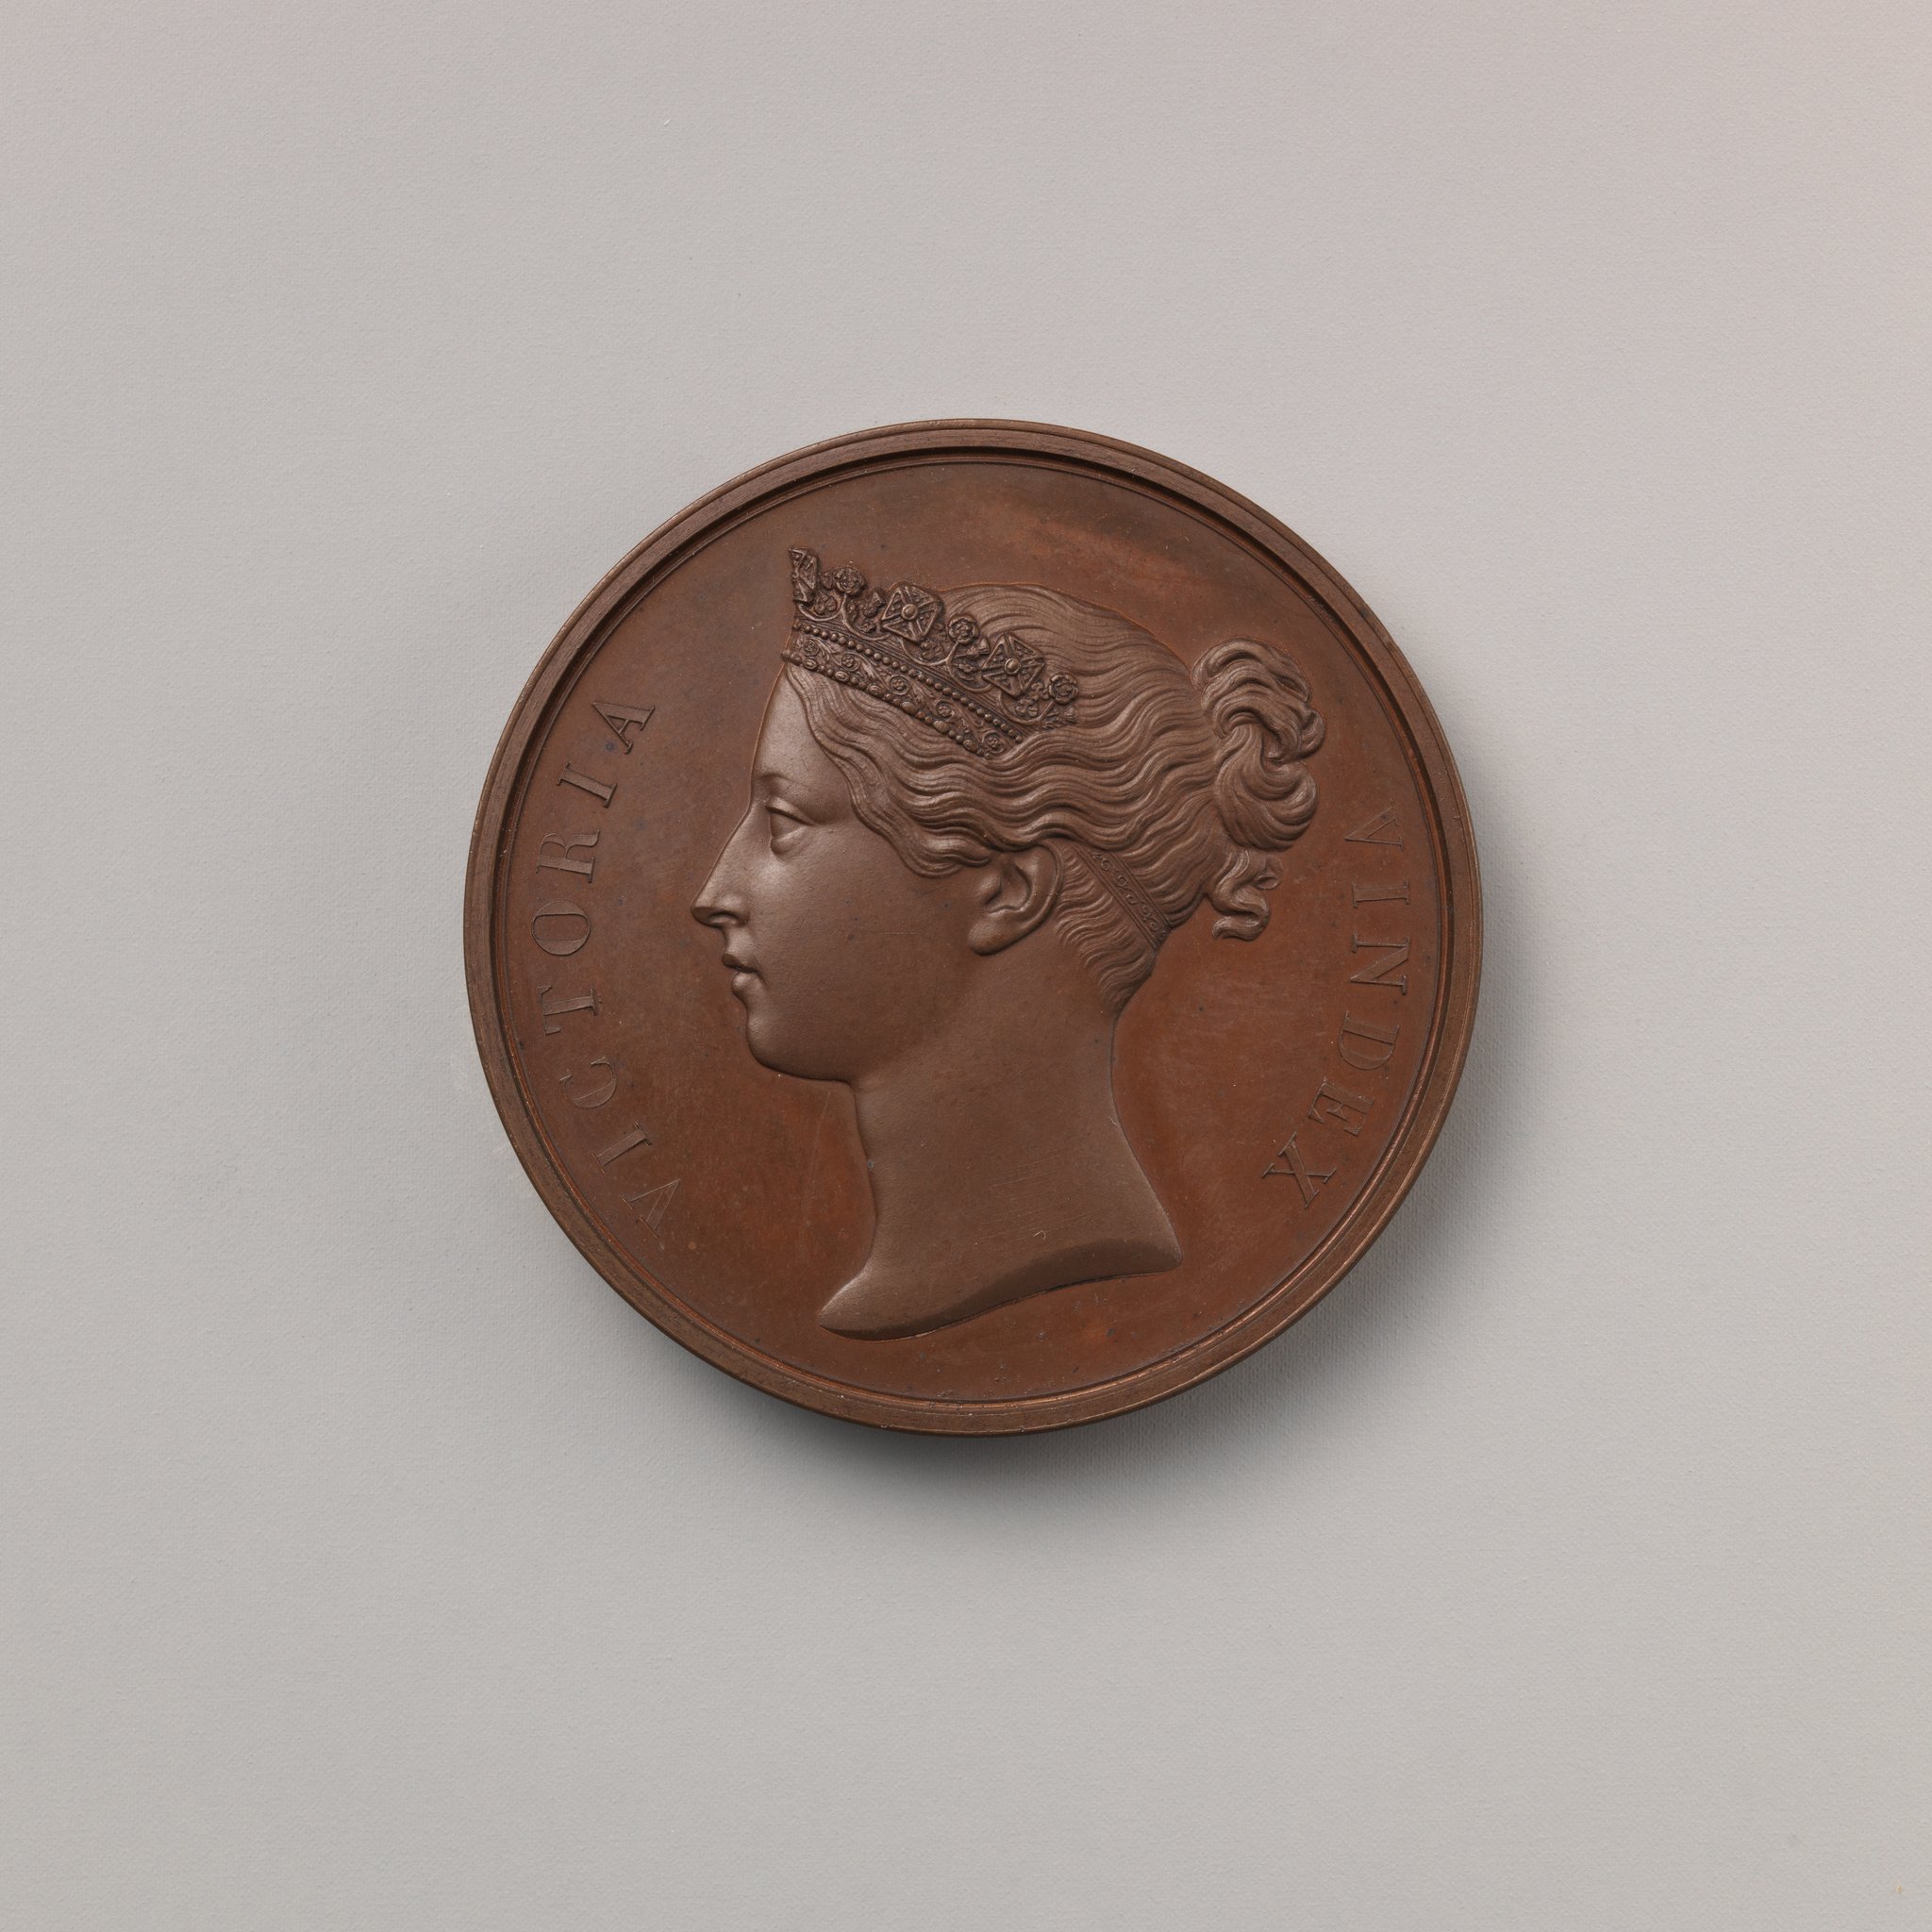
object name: medal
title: Fourth Form of the Afghanistan Medal, 1842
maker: william wyon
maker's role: artist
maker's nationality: british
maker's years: 1795-1851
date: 1842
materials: bronze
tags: queens,profiles